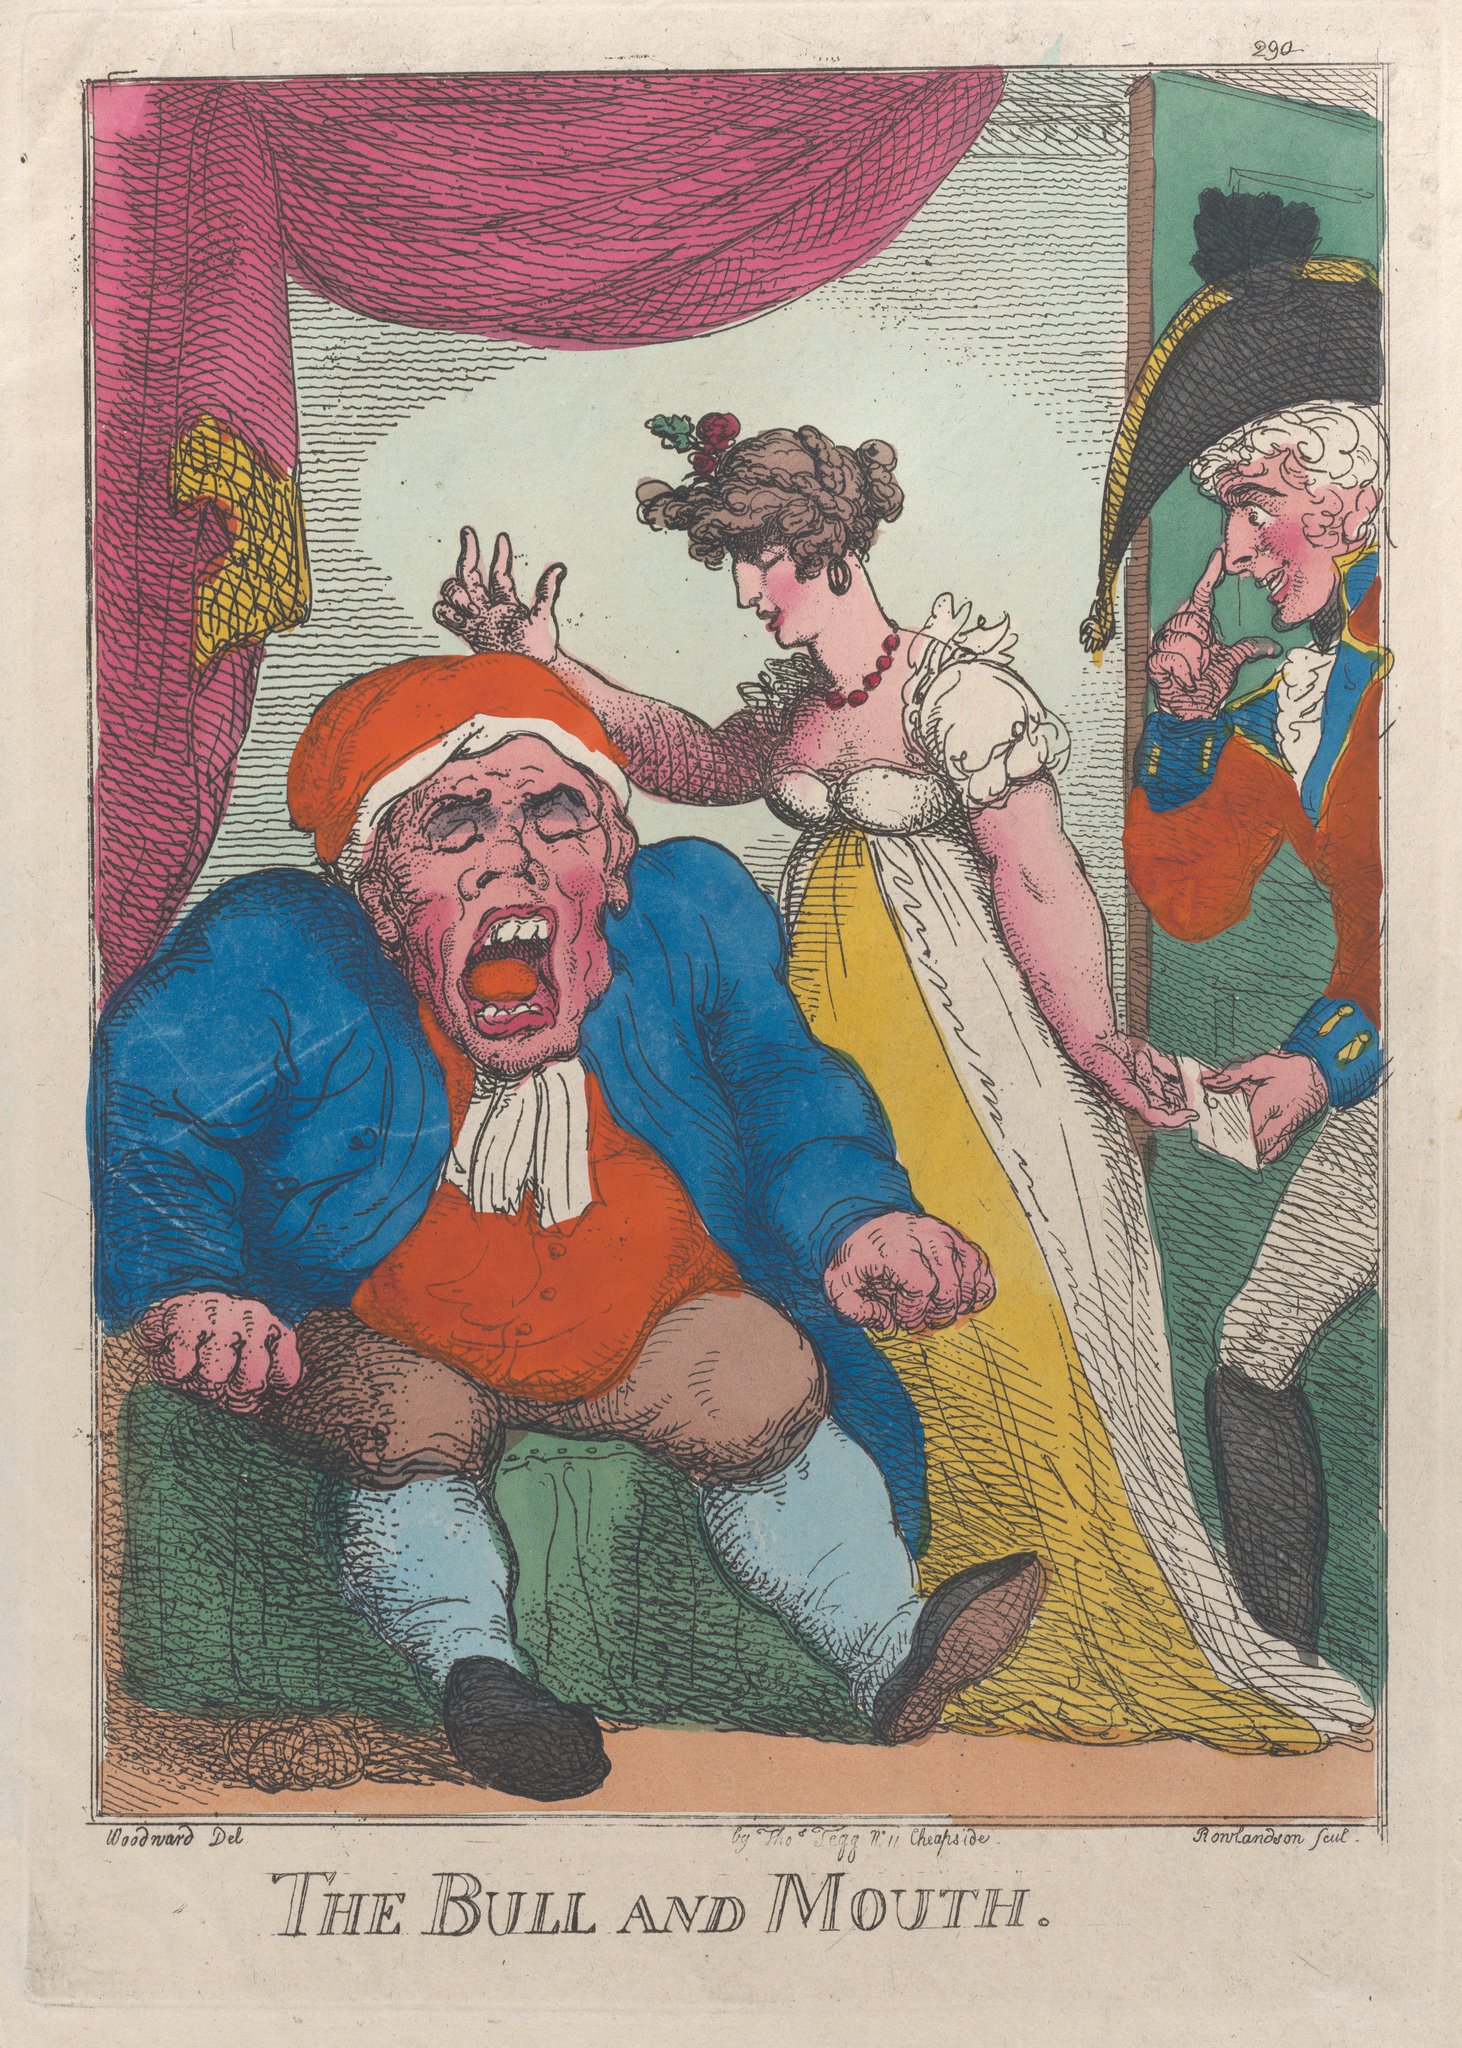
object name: print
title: The Bull and Mouth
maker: thomas rowlandson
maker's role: artist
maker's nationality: british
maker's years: 1757-1827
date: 1808-1809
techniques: etching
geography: london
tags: satire,men,women